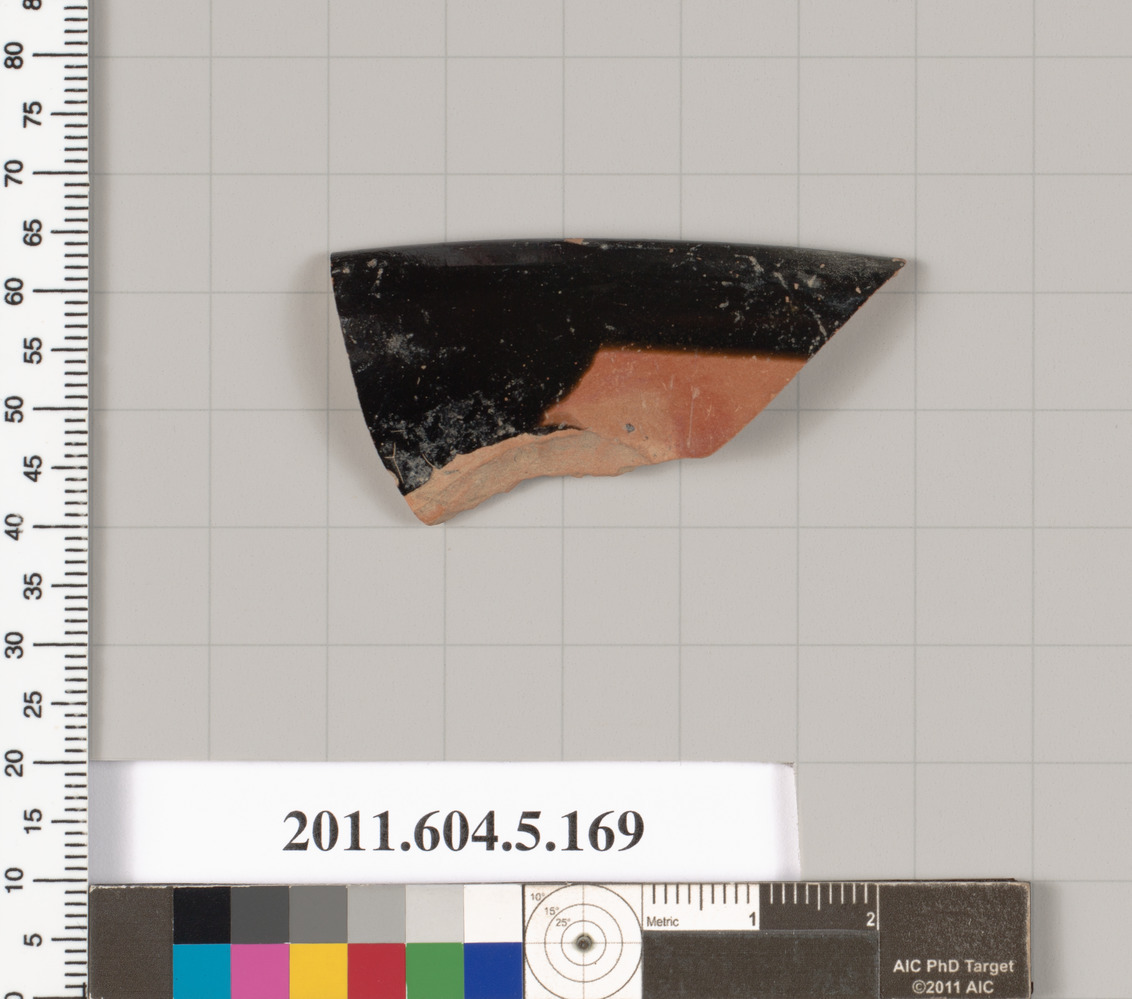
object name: kylix fragment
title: Terracotta rim fragment of a kylix (drinking cup)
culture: greek, attic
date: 600-401 BCE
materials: terracotta